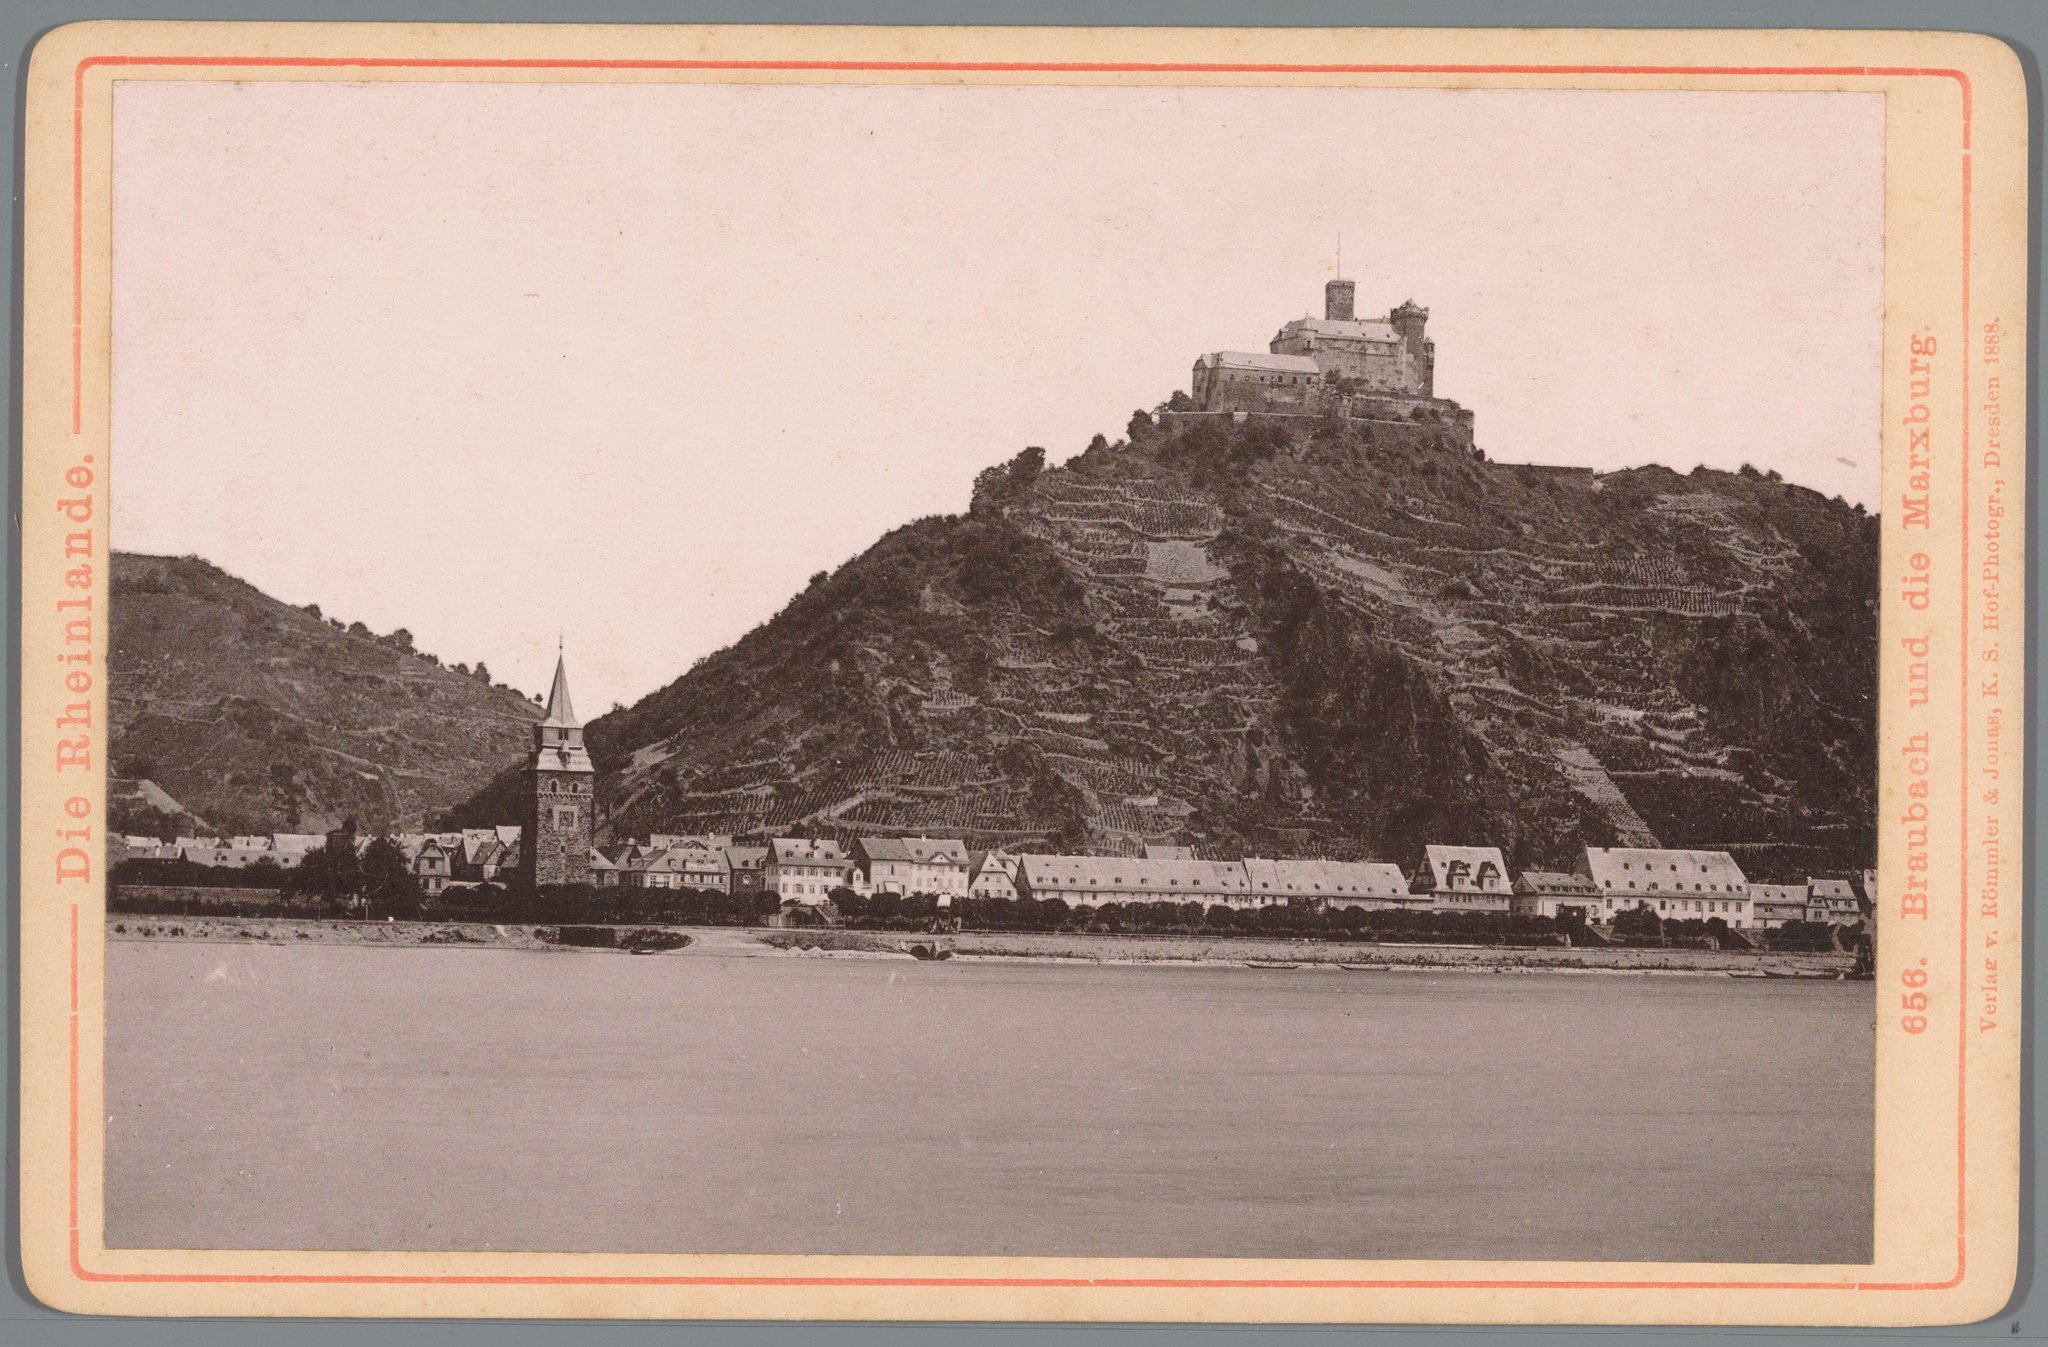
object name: photomechanical print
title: Gezicht op Braubach en de Marksburg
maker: Anonymous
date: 1888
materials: cardboard, paper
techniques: photograph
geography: dresden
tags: castle, river, mountains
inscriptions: name: ‘Vosmaer’, number: ‘656.’